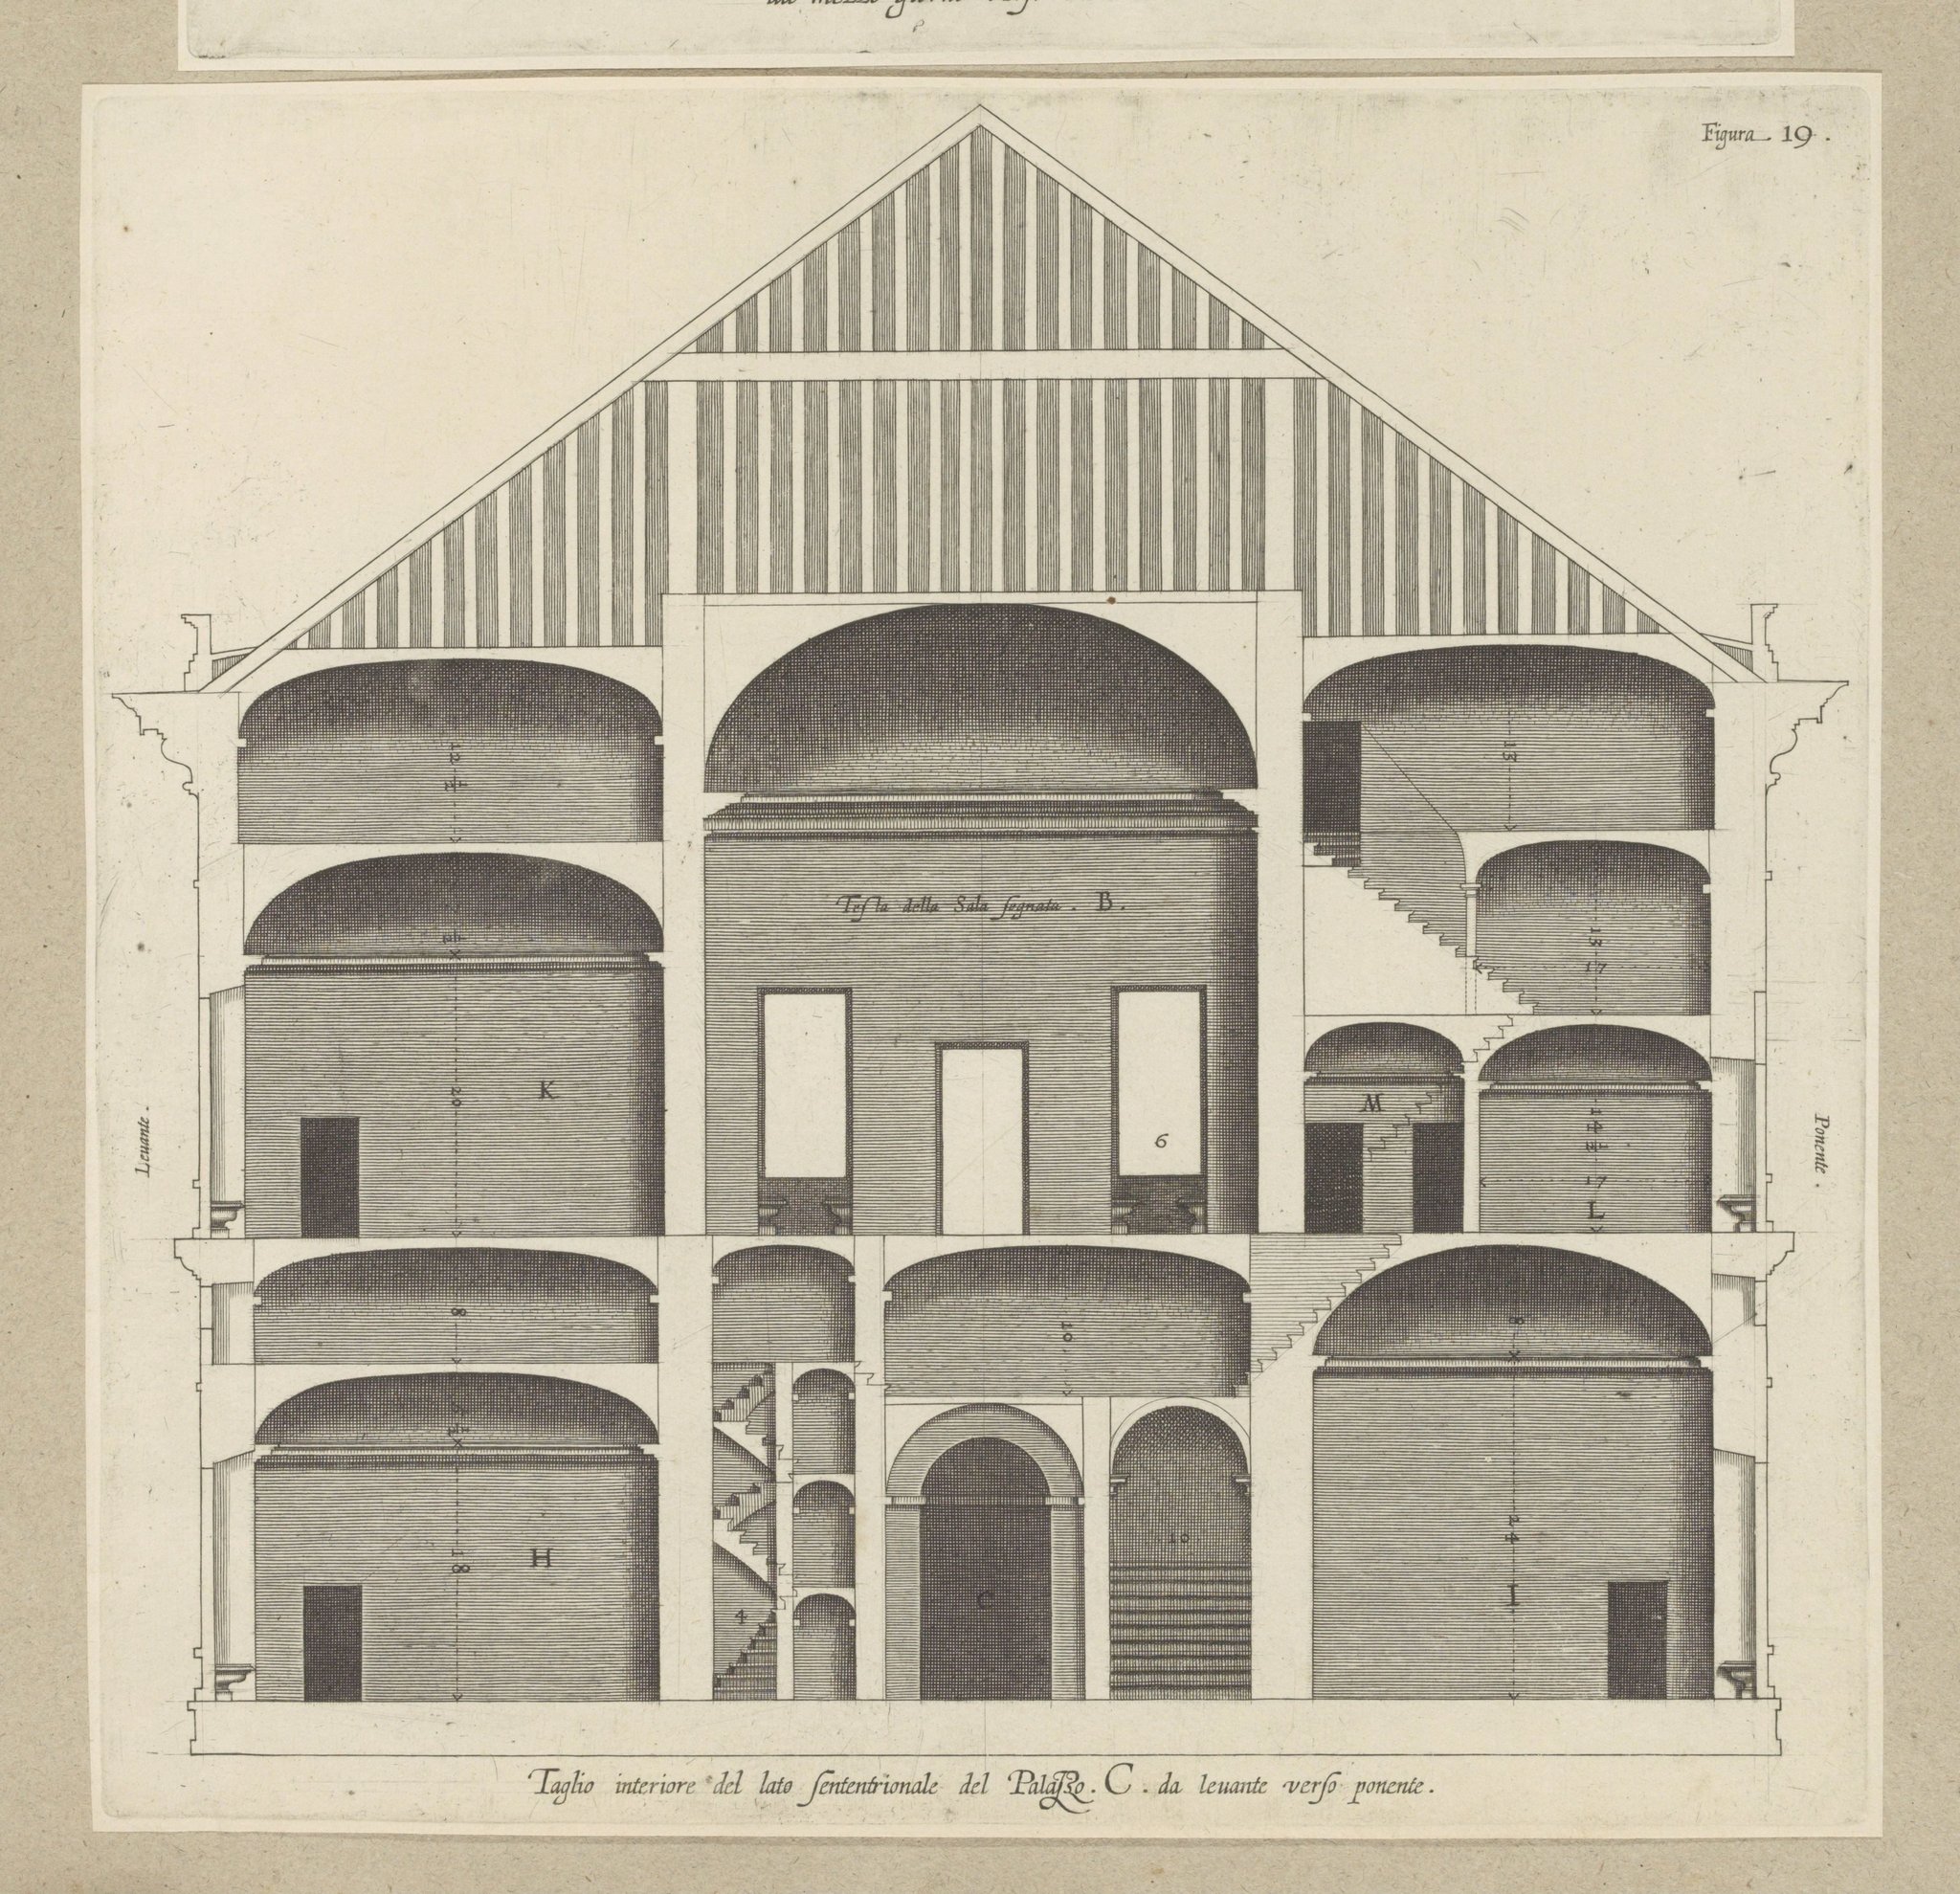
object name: print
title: Dwarsdoorsnede van de Villa Spinola di San Pietro te Genua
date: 1622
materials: paper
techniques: engraving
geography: antwerp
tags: hôtel, i.e. small palace in city - aa - civic architecture: inside, section ~ architectural design or model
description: Deze prent maakt deel uit van een album.